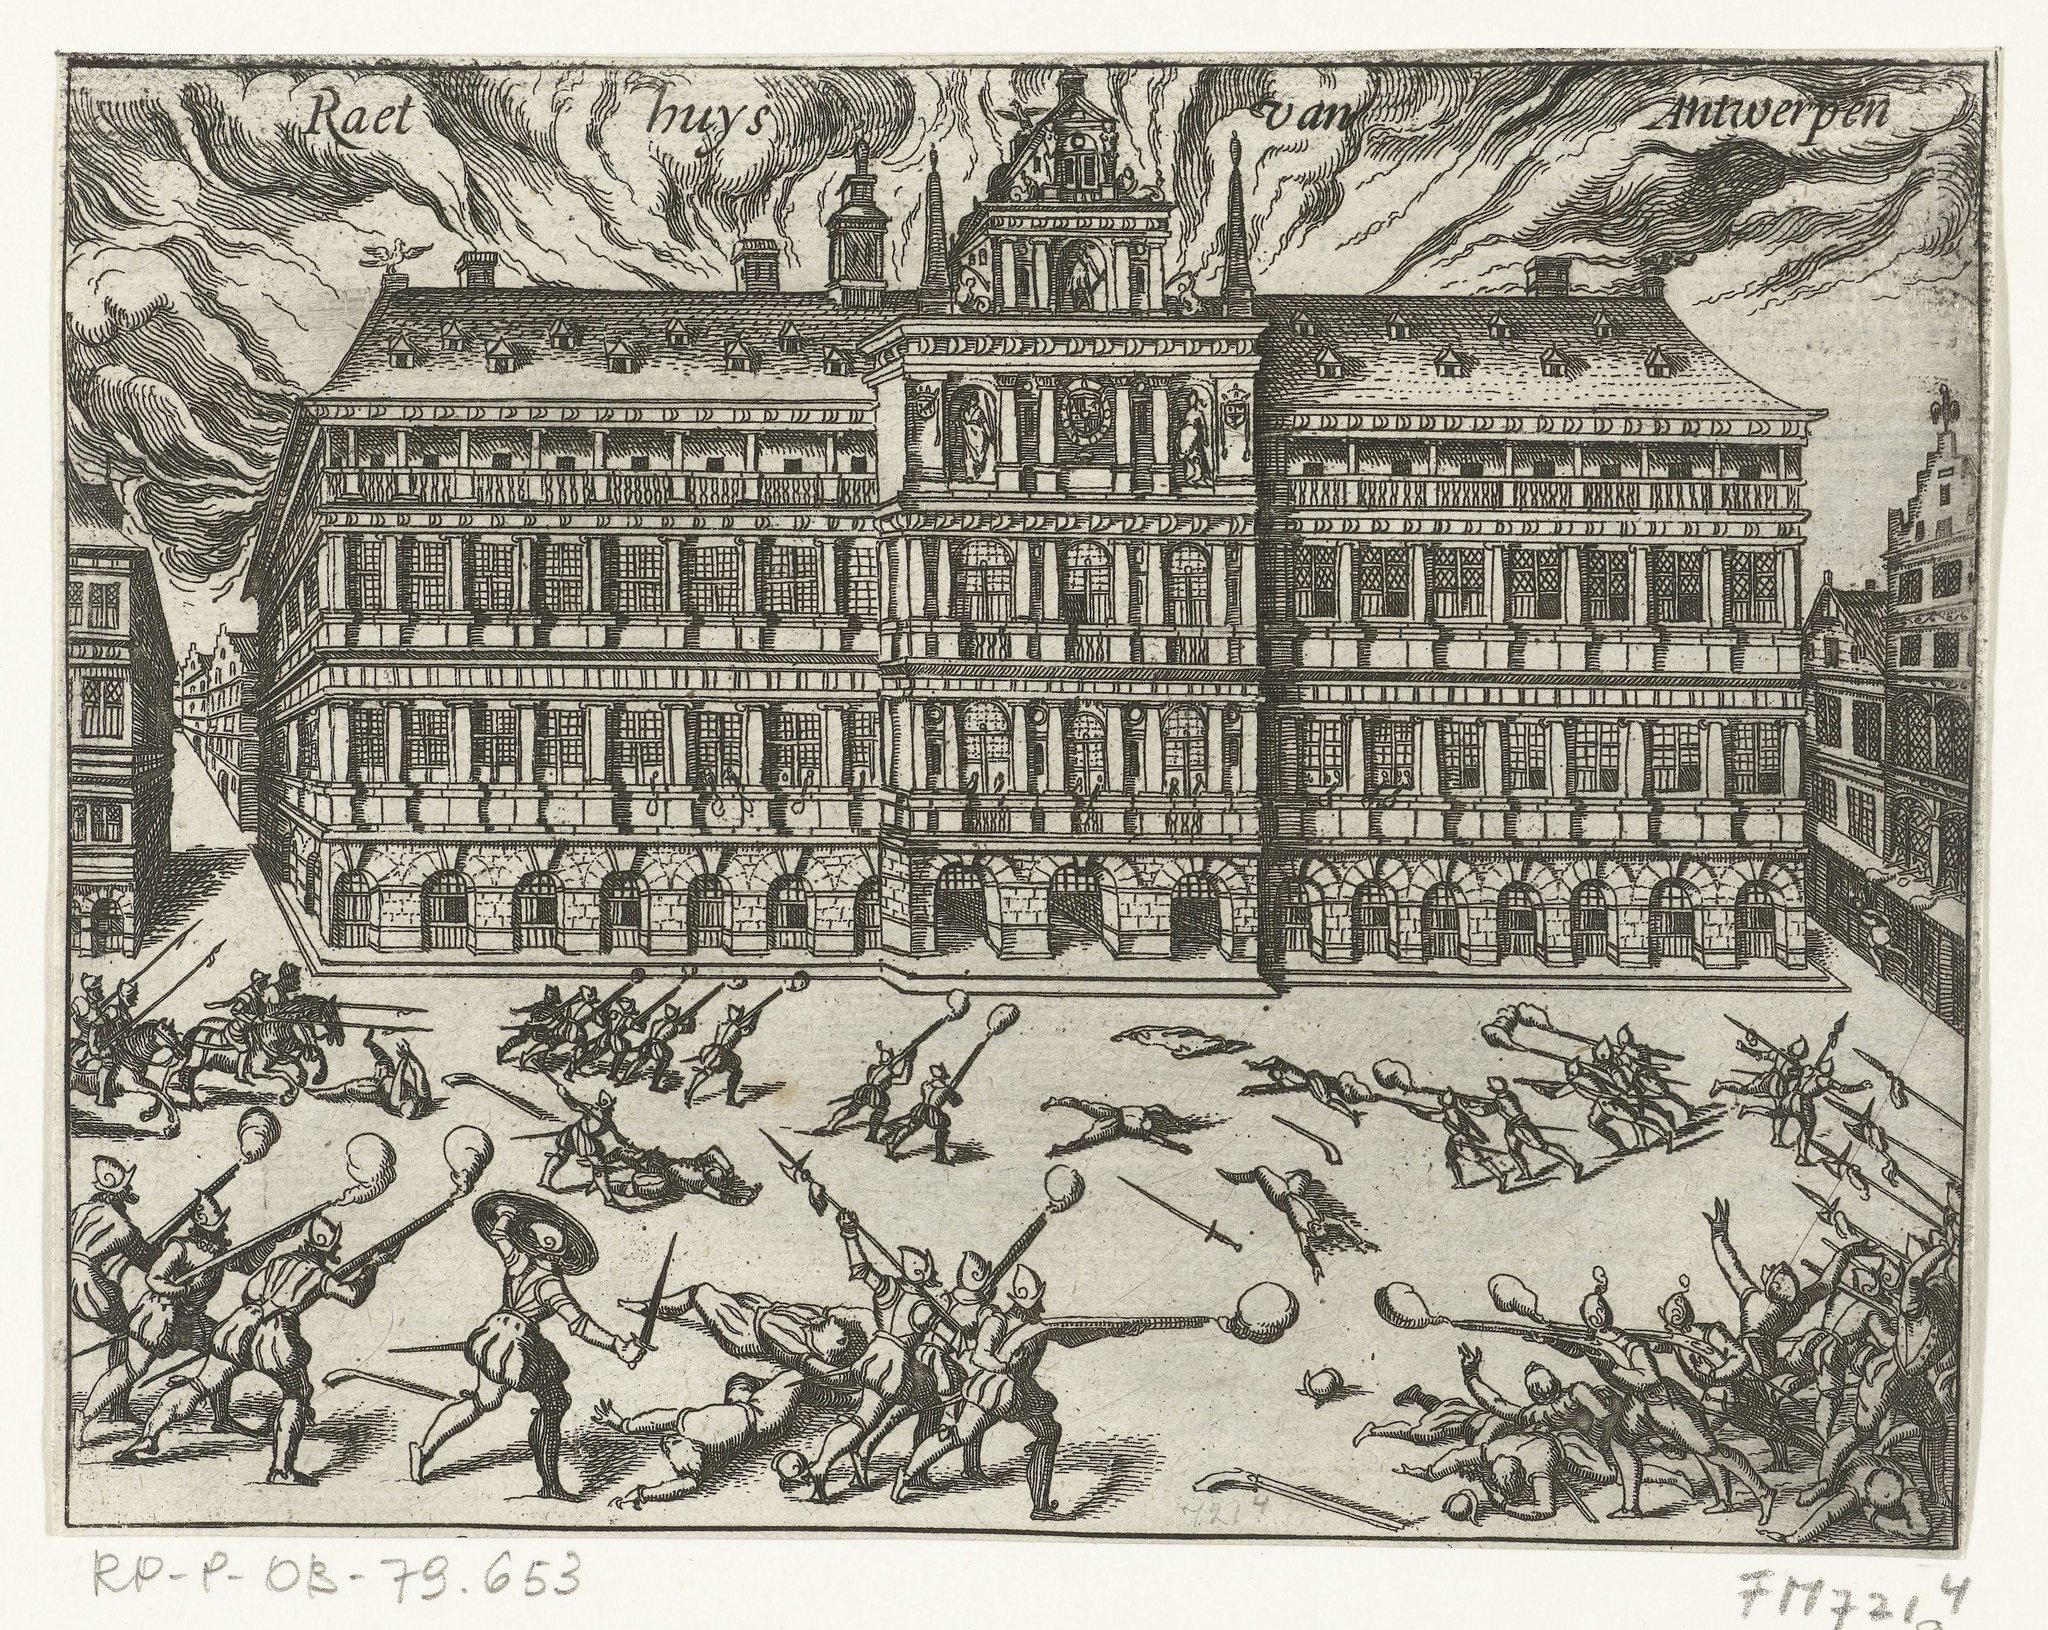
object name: print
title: Spaanse Furie: stadhuis in brand, 1576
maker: Anonymous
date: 1613-1615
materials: paper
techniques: etching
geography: netherlands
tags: on fire, ablaze, massacre ~ war, antwerp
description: Spaanse Furie te Antwerpen, 4-7 november 1576. Het stadhuis van Antwerpen in brand. Op de Grote Markt voor het stadhuis gevechten tussen soldaten. Marge met onderschrift en nummer afgesneden. Bedrukt op achterzijde met tekst in het Nederlands en fragment van de voorstelling met de beschieting van de stad.